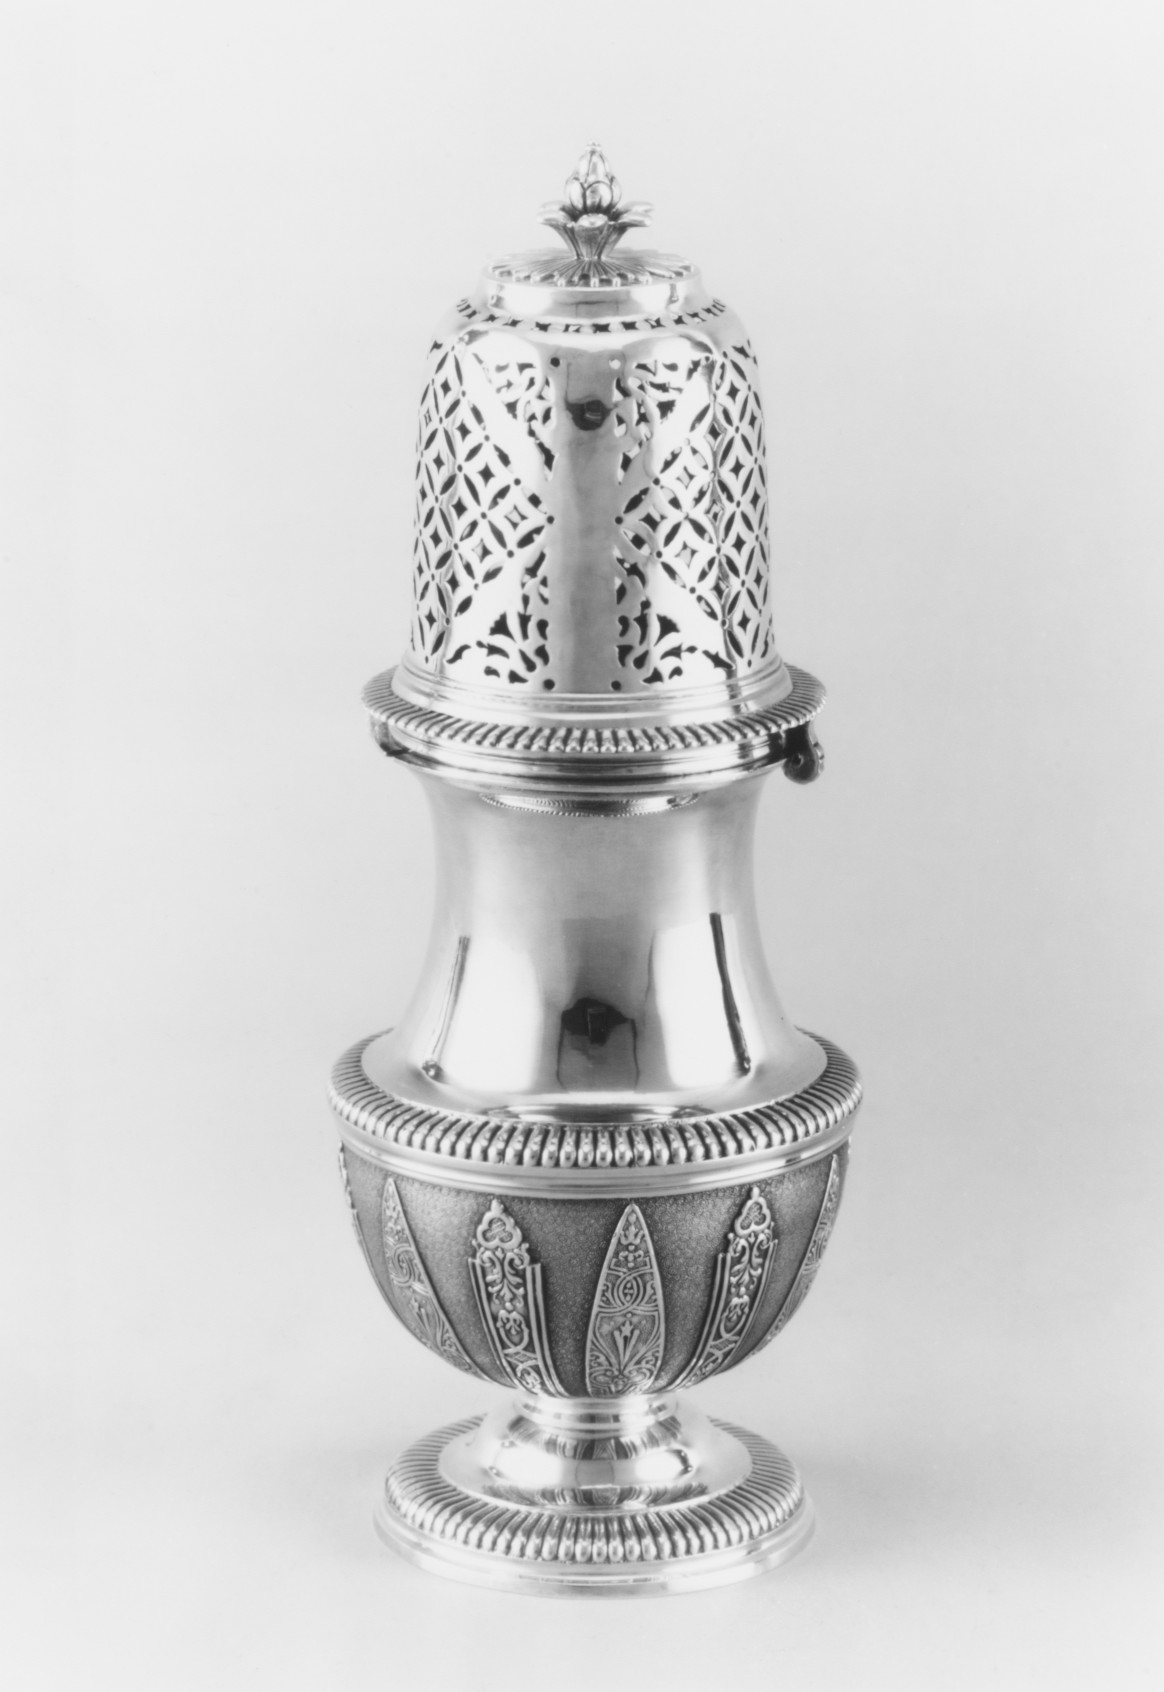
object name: sugar caster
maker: ferdinand lachèse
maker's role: maker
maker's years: 1698-1756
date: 1740-1742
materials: silver